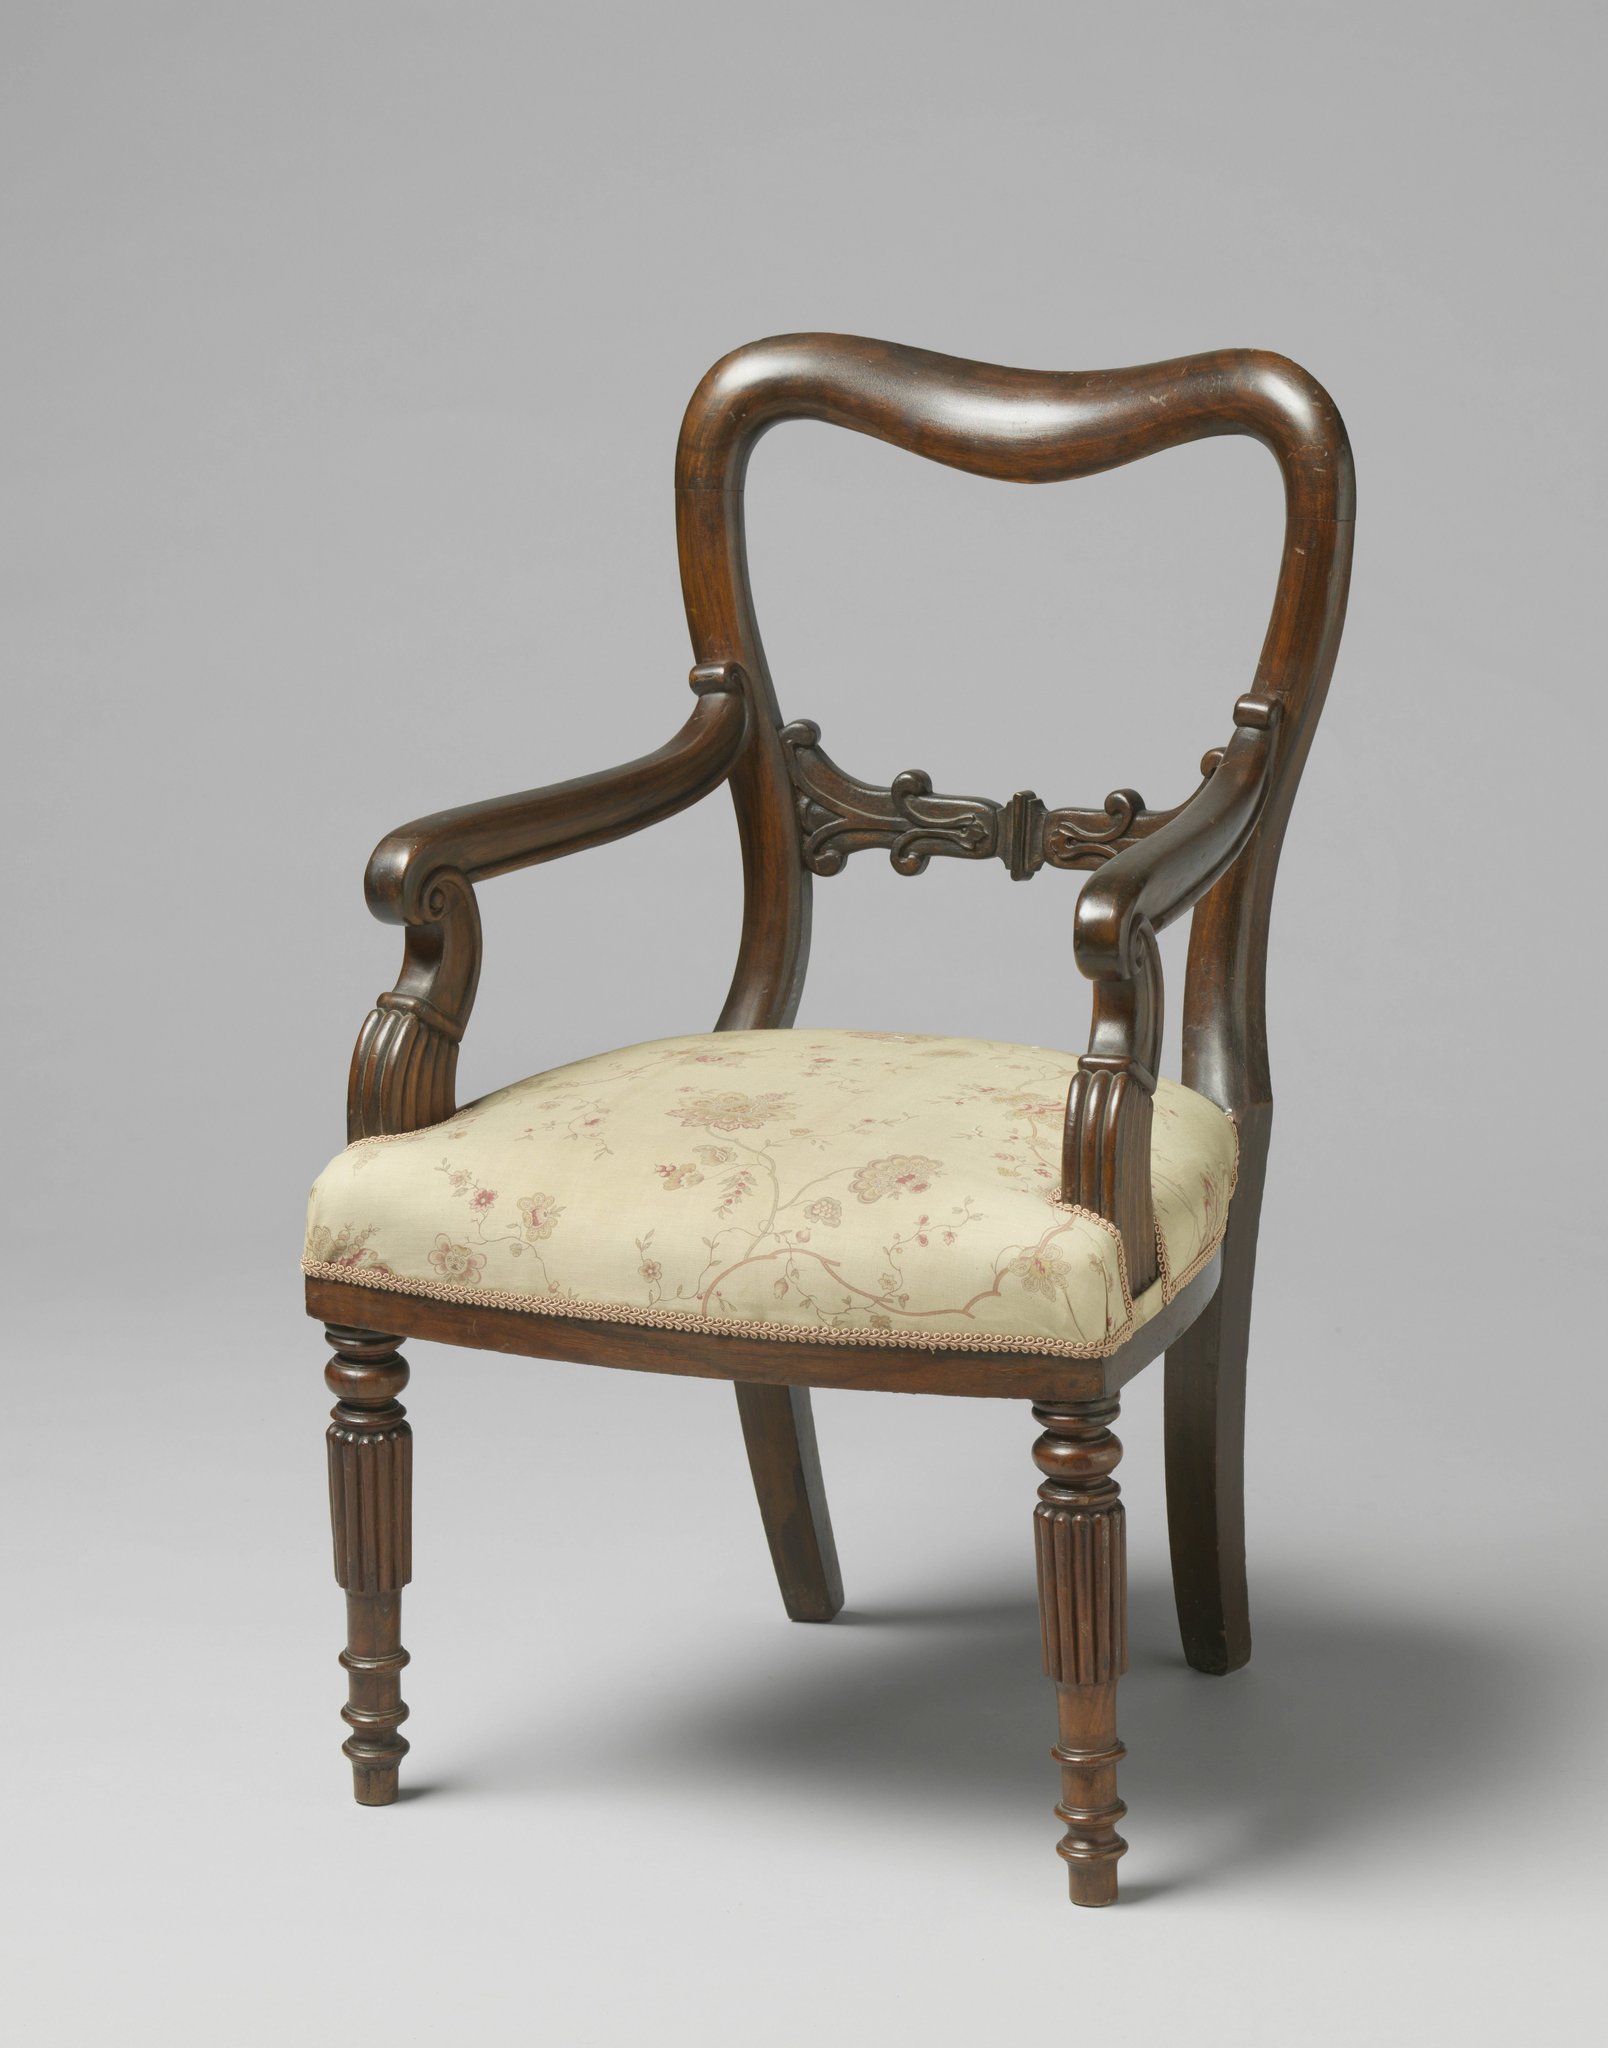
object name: furniture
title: Meubilair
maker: Anonymous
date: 1850-1875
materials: wood, textile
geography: northern netherlands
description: Armstoel uit mahoniehouten kinderameublement bestaande uit drie stoelen en twee armstoelen. De ronde voorpoten zijn versierd met draaiwerk en met een rand van halfronde profielen. De sabelvormige achterpoten lopen over in het rugraam met gebogen stijlen en bovendorpel en met een tussenregel, versierd met symmetrisch geplaatste bladkelken, waartussen een verticaal geprofileerd sluitstuk. De S-vormige armleggers en stutten eindigen in een voluut; de onderzijde van de stutten dragen halfronde profielen. Beklede zitting.